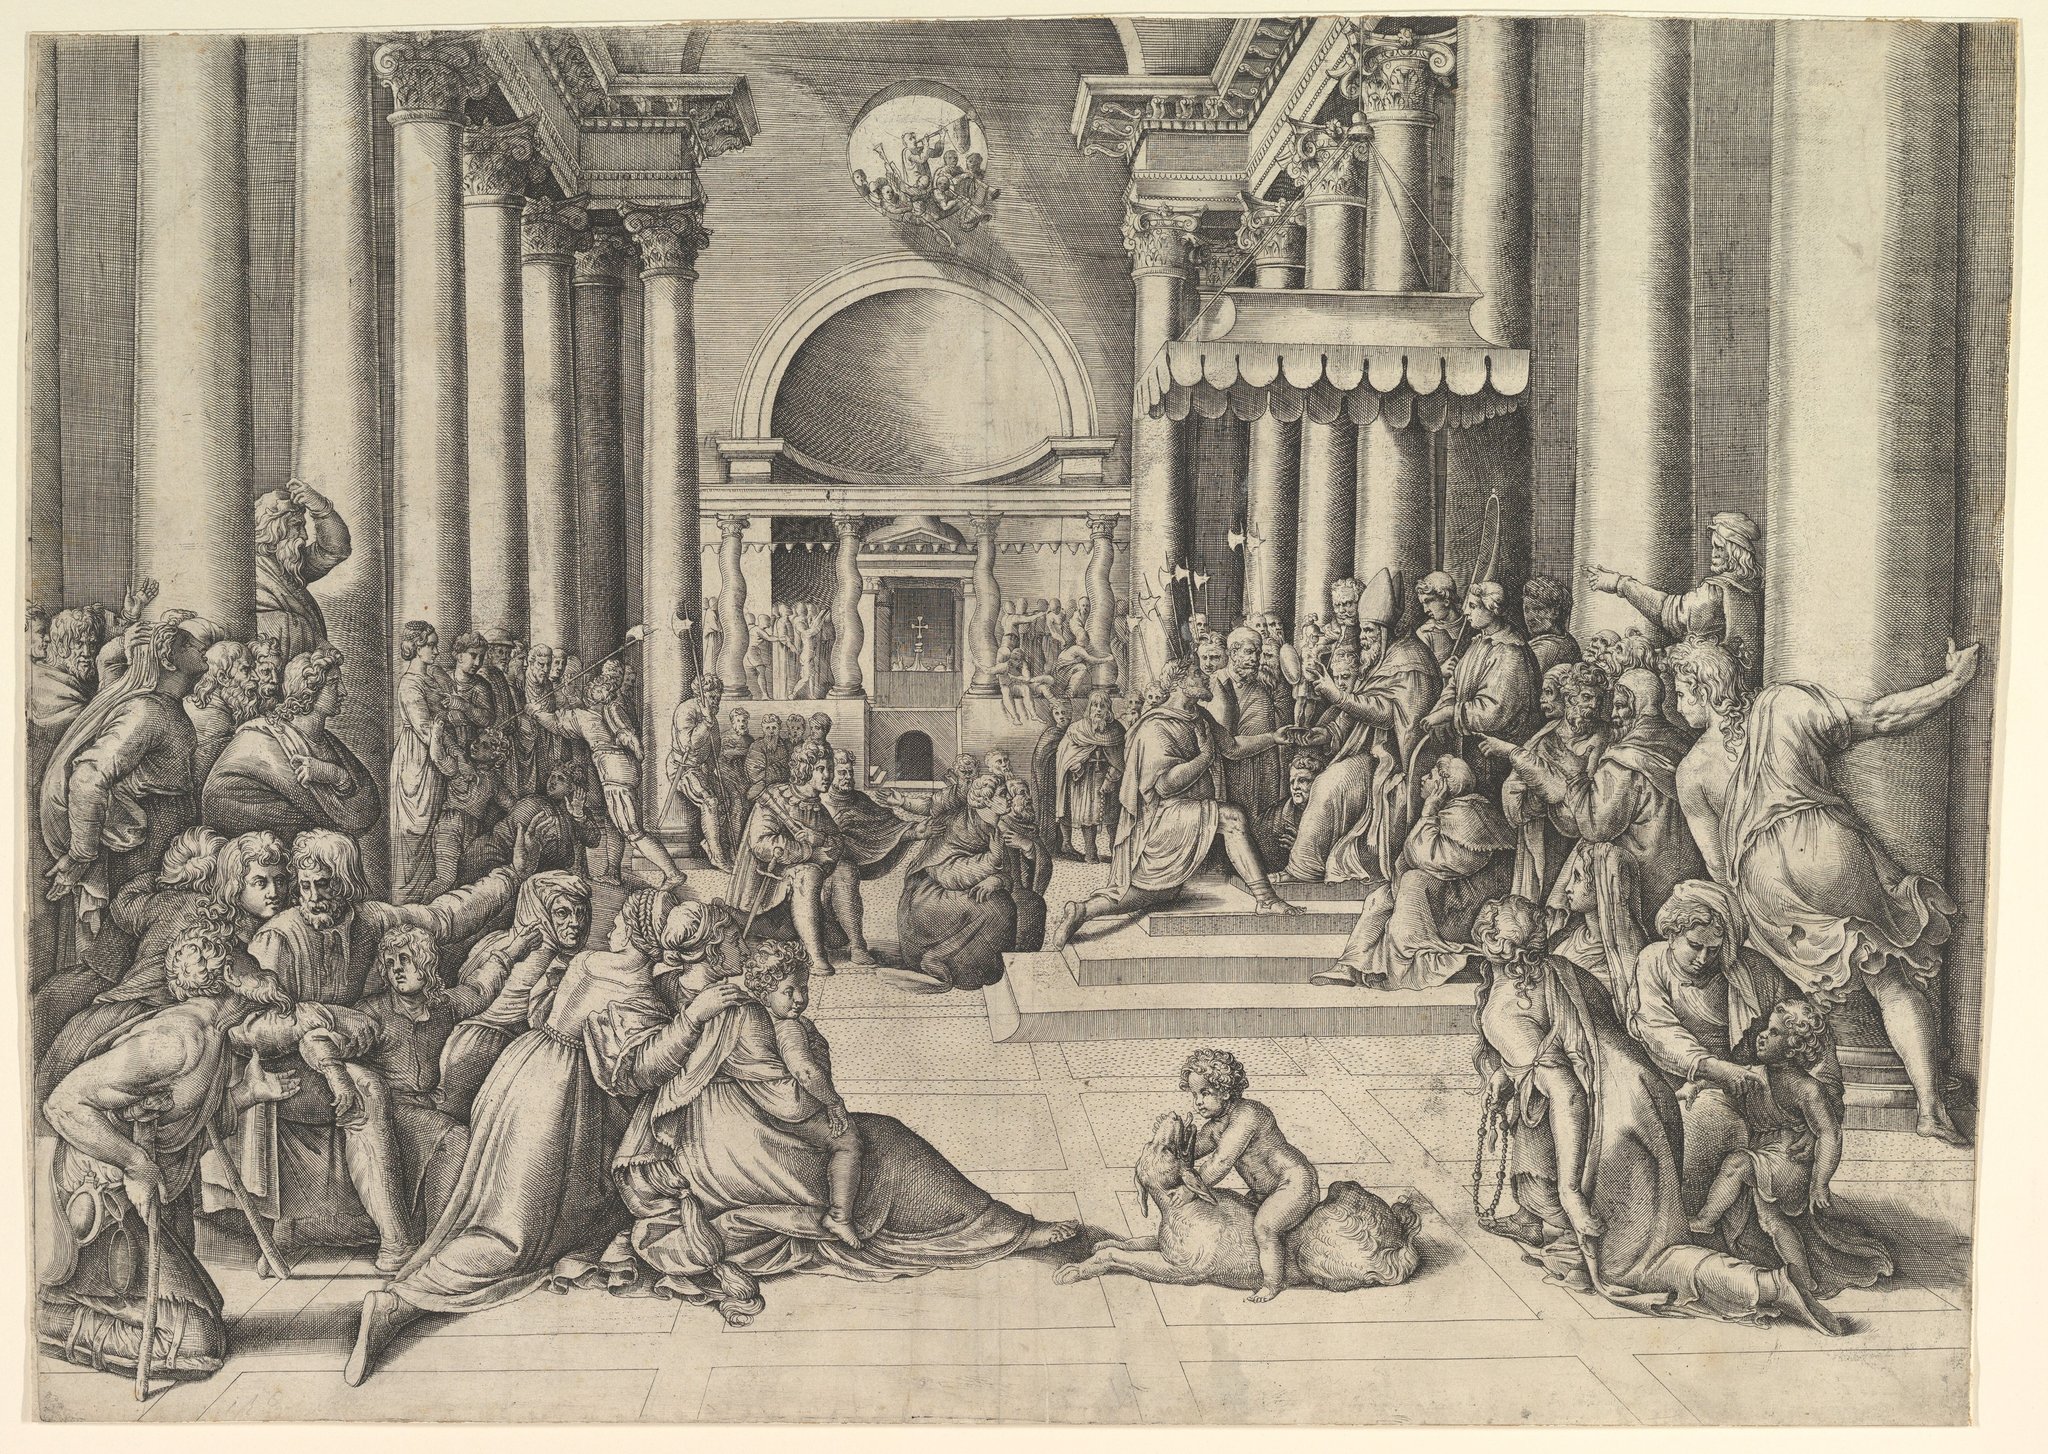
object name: print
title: Constantine Presenting the City of Rome to the Holy See, at right, many spectators throughout, a child playing with a dog in the foreground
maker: battista franco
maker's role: artist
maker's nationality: italian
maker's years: 1510-1561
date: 1530-1561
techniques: engraving, etching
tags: boys,men,women,dogs